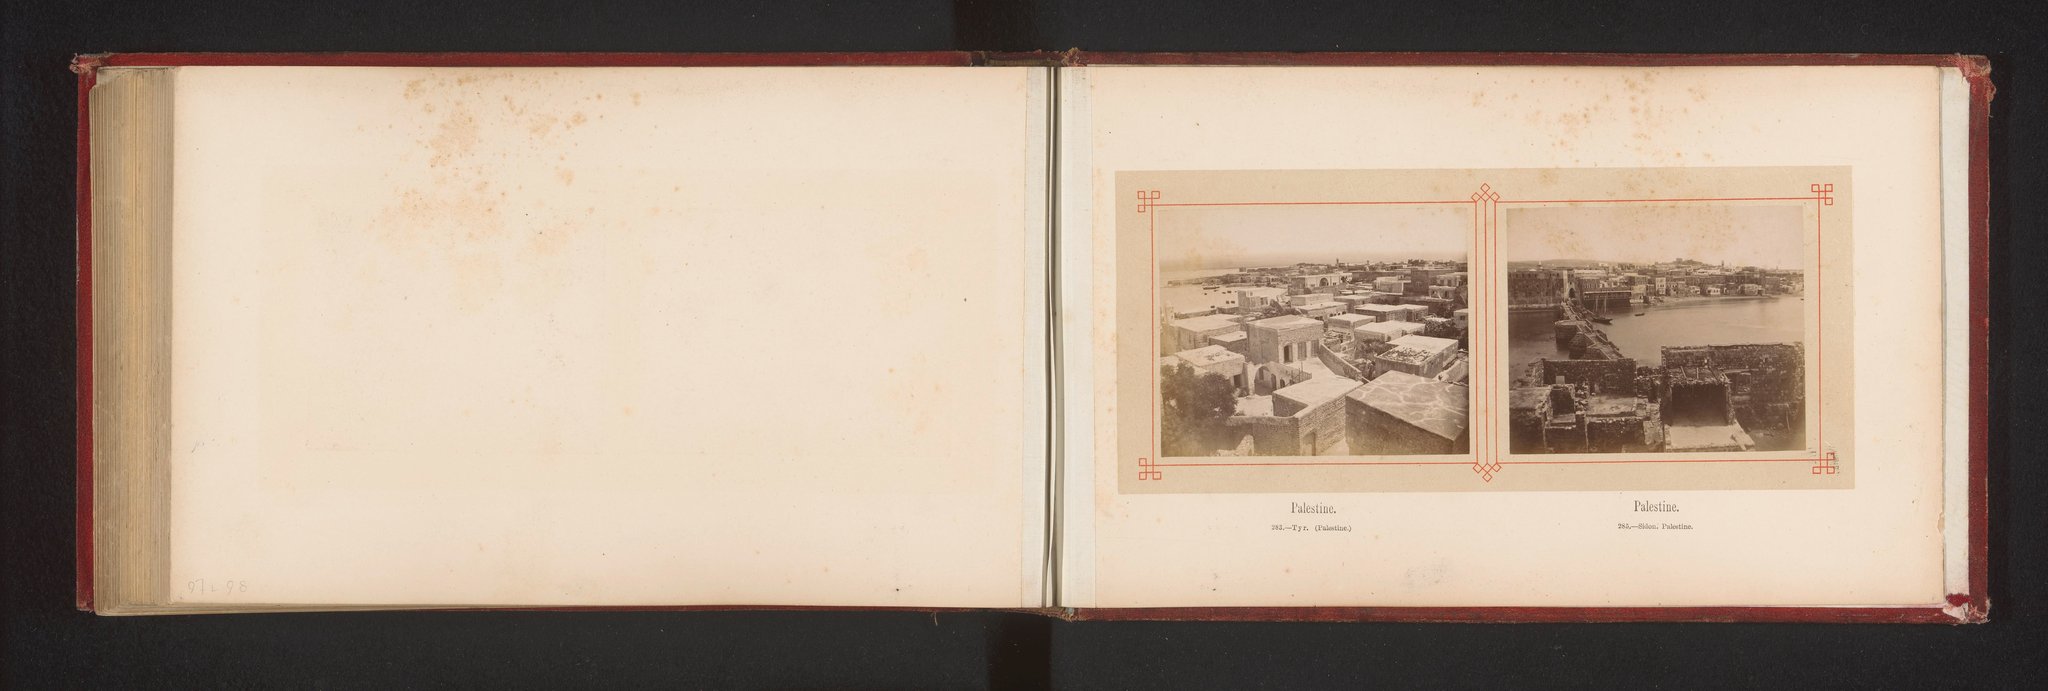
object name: photograph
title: Palestine - 283.- Tyr.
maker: félix bonfils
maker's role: fotograaf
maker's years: 1831-1885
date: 1873-1878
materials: photographic support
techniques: albumen print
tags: city-view in general; 'veduta'